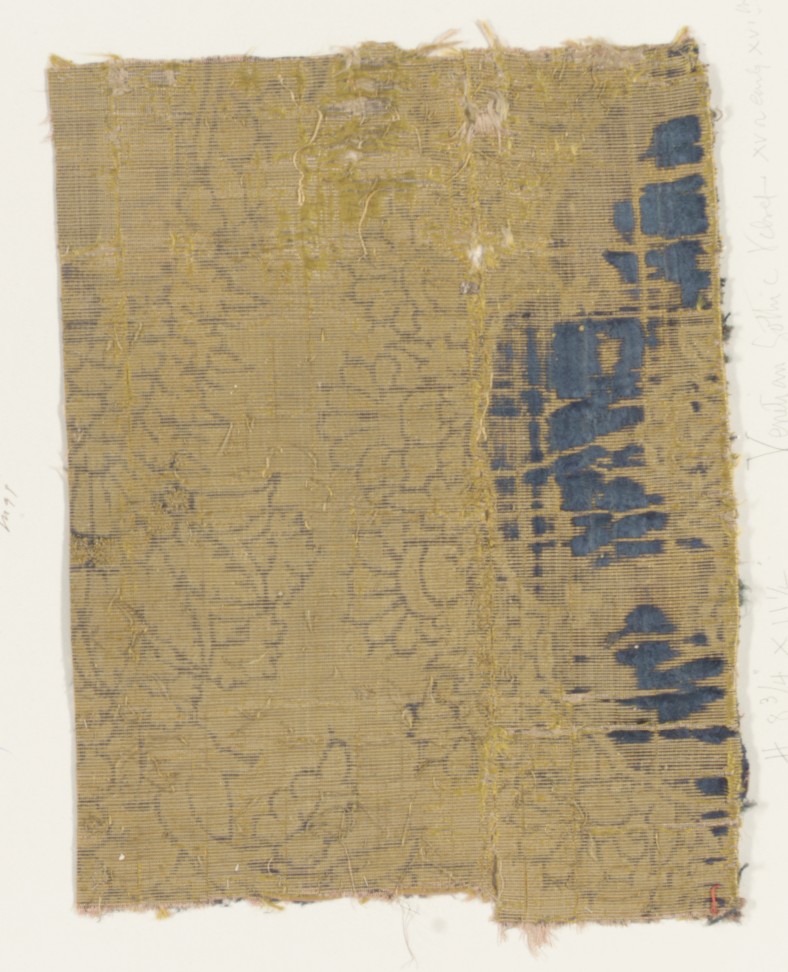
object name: fragment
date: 1401-1600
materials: metal thread, silk